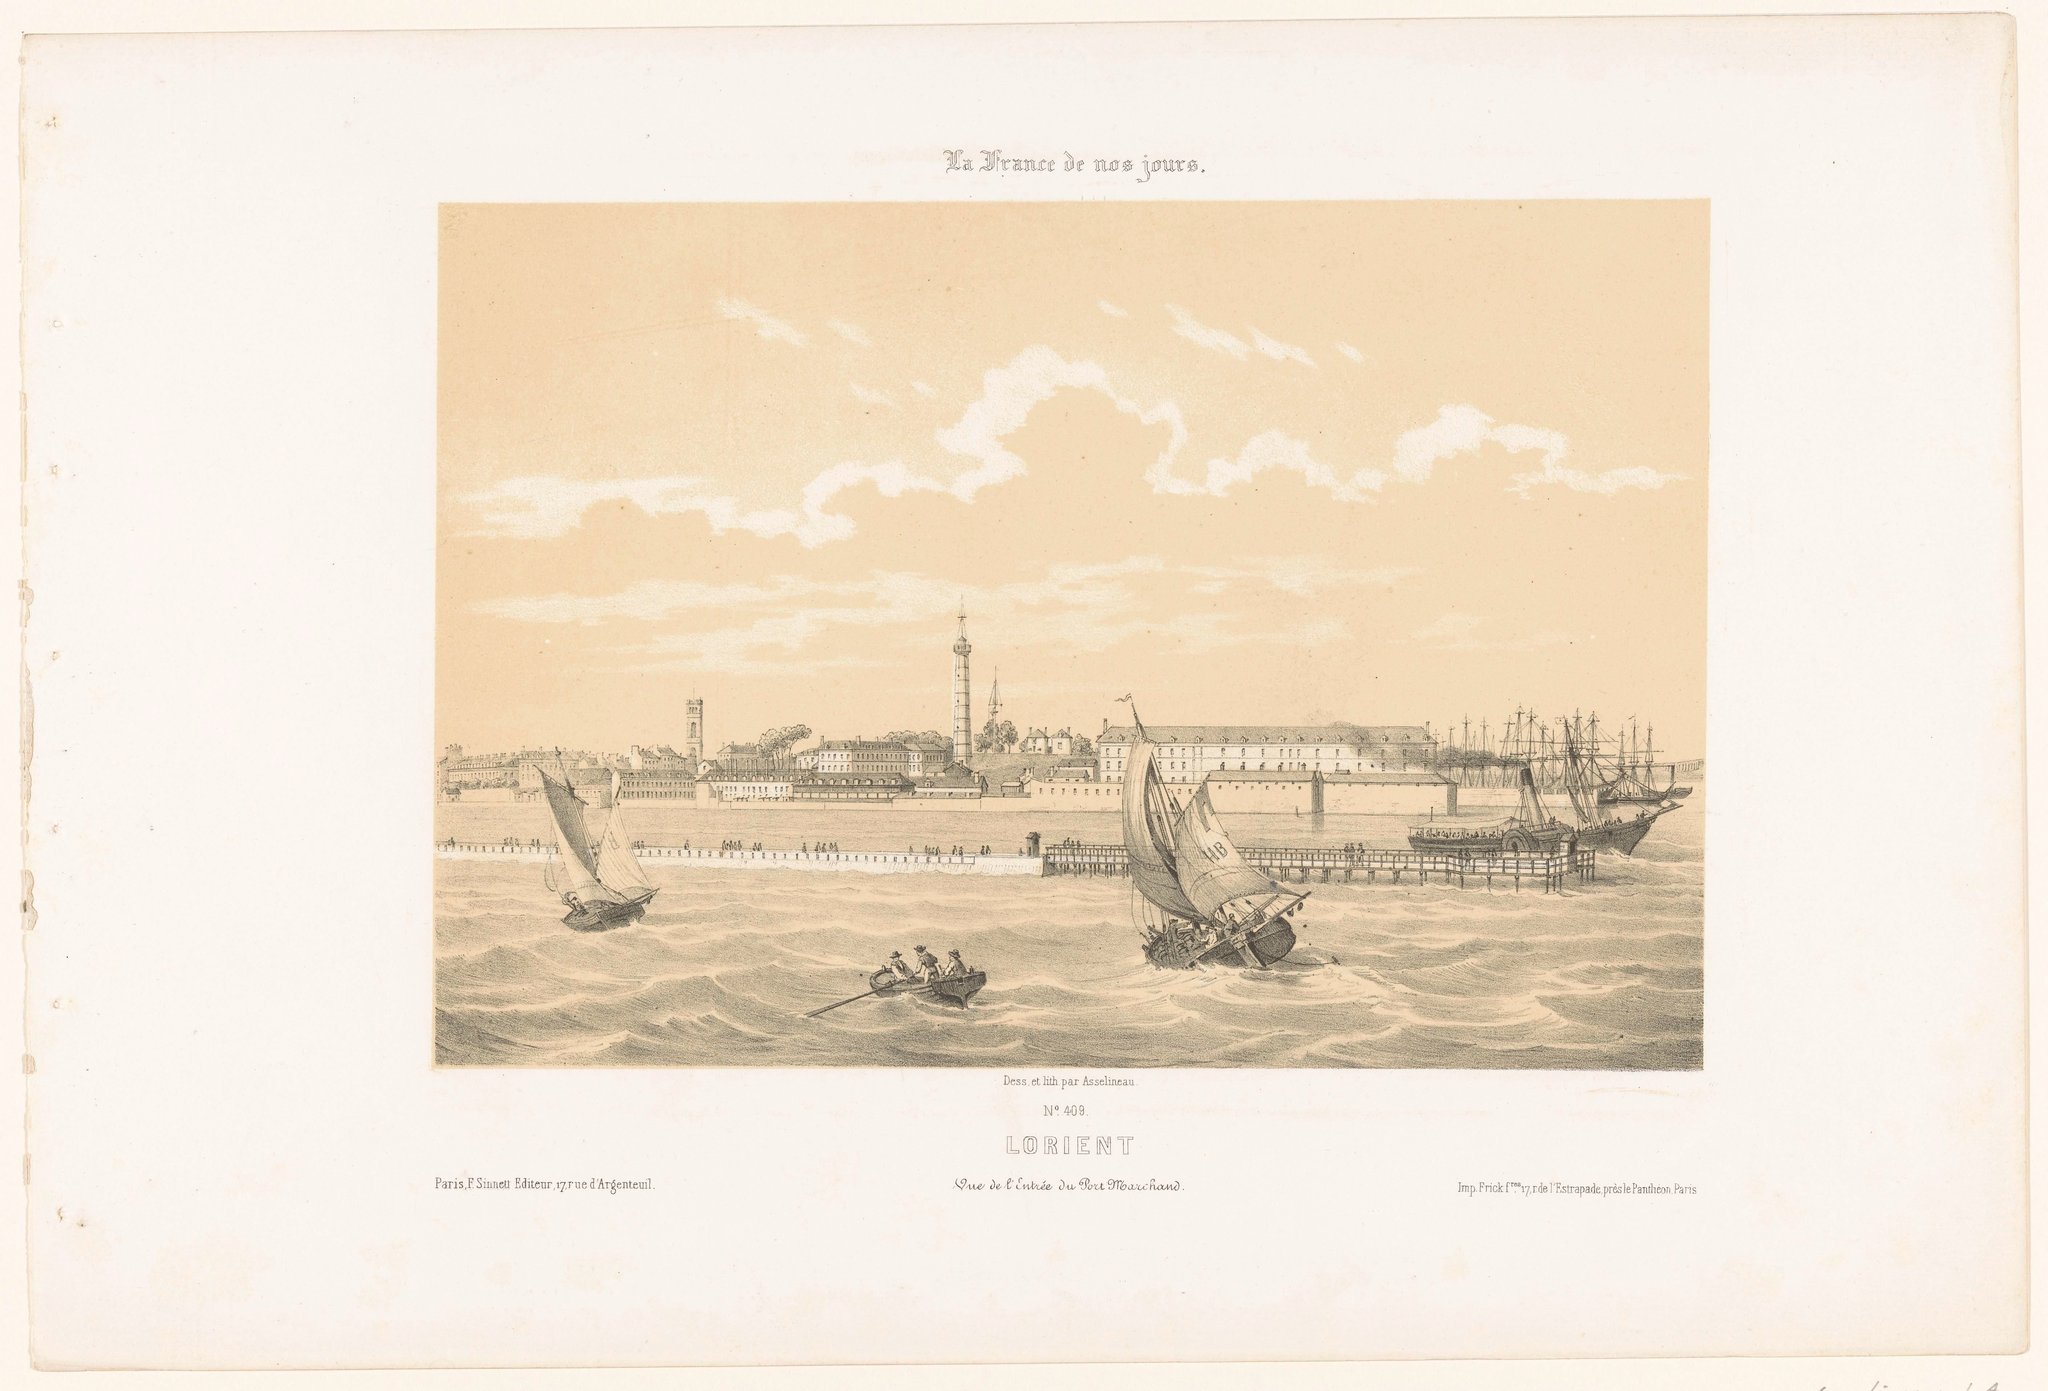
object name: print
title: Lorient. Vue de l'éntrée du port Marchand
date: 1863-1864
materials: paper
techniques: tone lithography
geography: rouen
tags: harbour, ships (in general) - cc - more than one ship, pier, quay, wharf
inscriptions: collector's mark: Lugt 2228